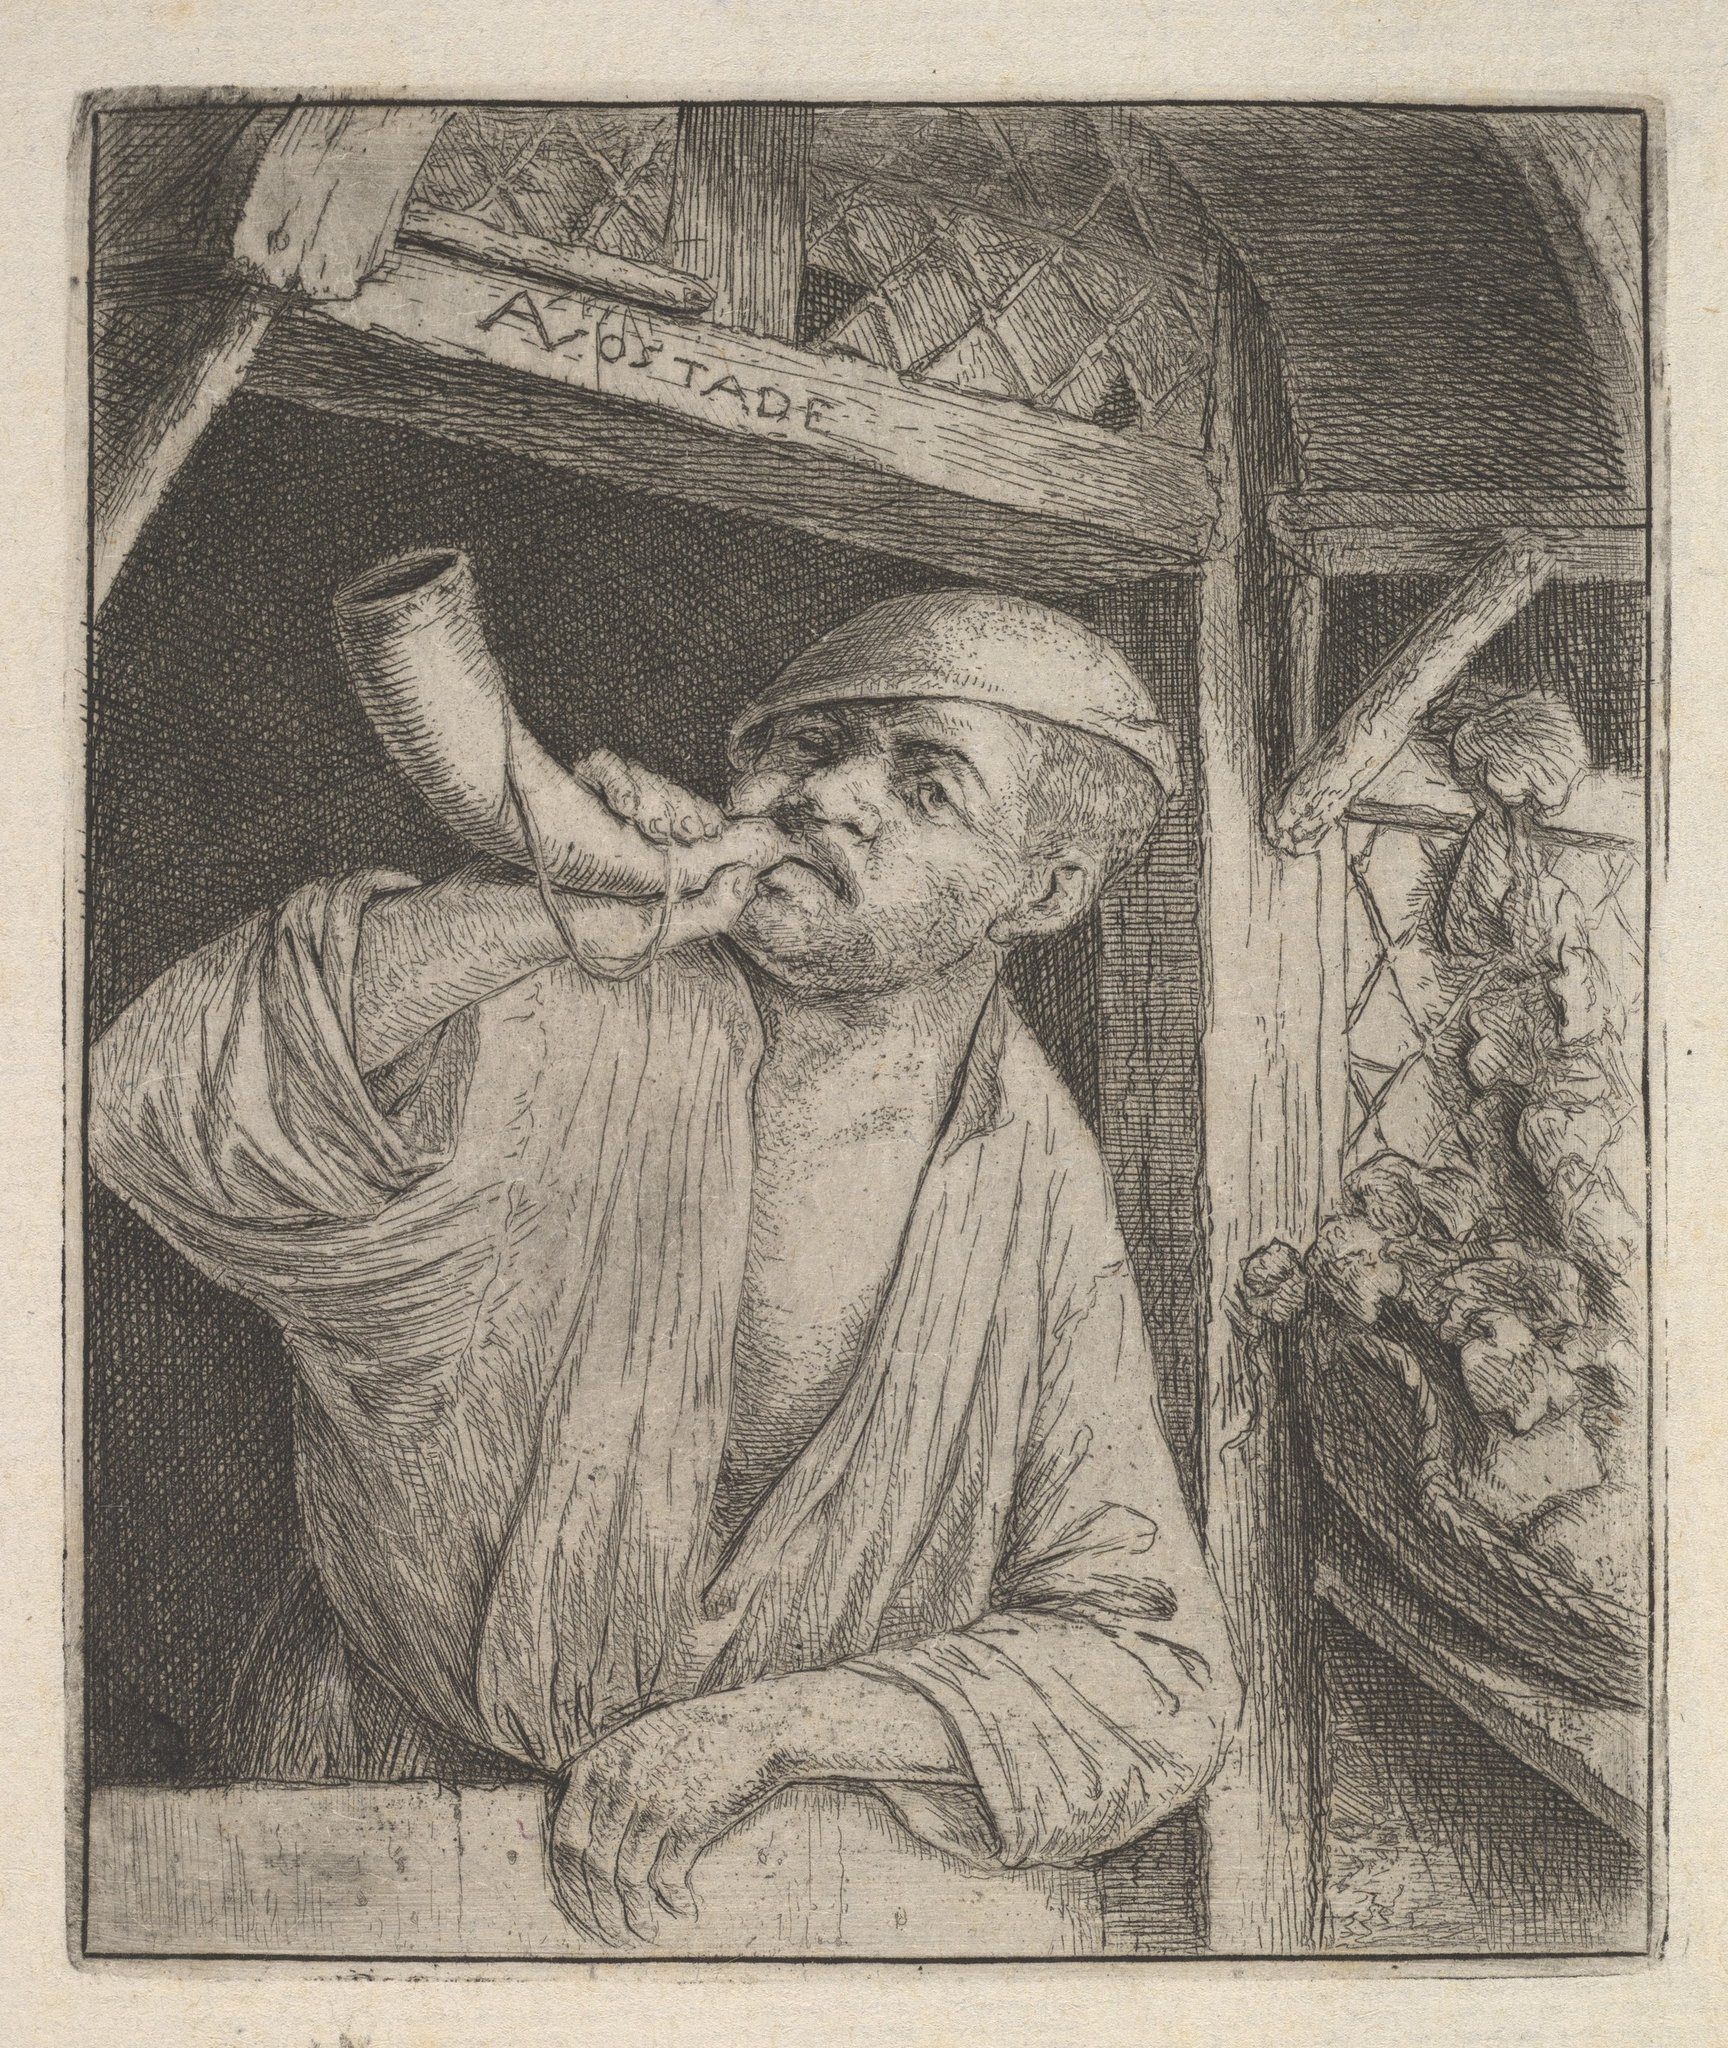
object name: print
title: Baker Blowing Horn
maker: adriaen van ostade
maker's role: artist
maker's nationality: dutch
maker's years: 1610-1685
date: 1610-1685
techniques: drypoint, etching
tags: men,horns,bakers